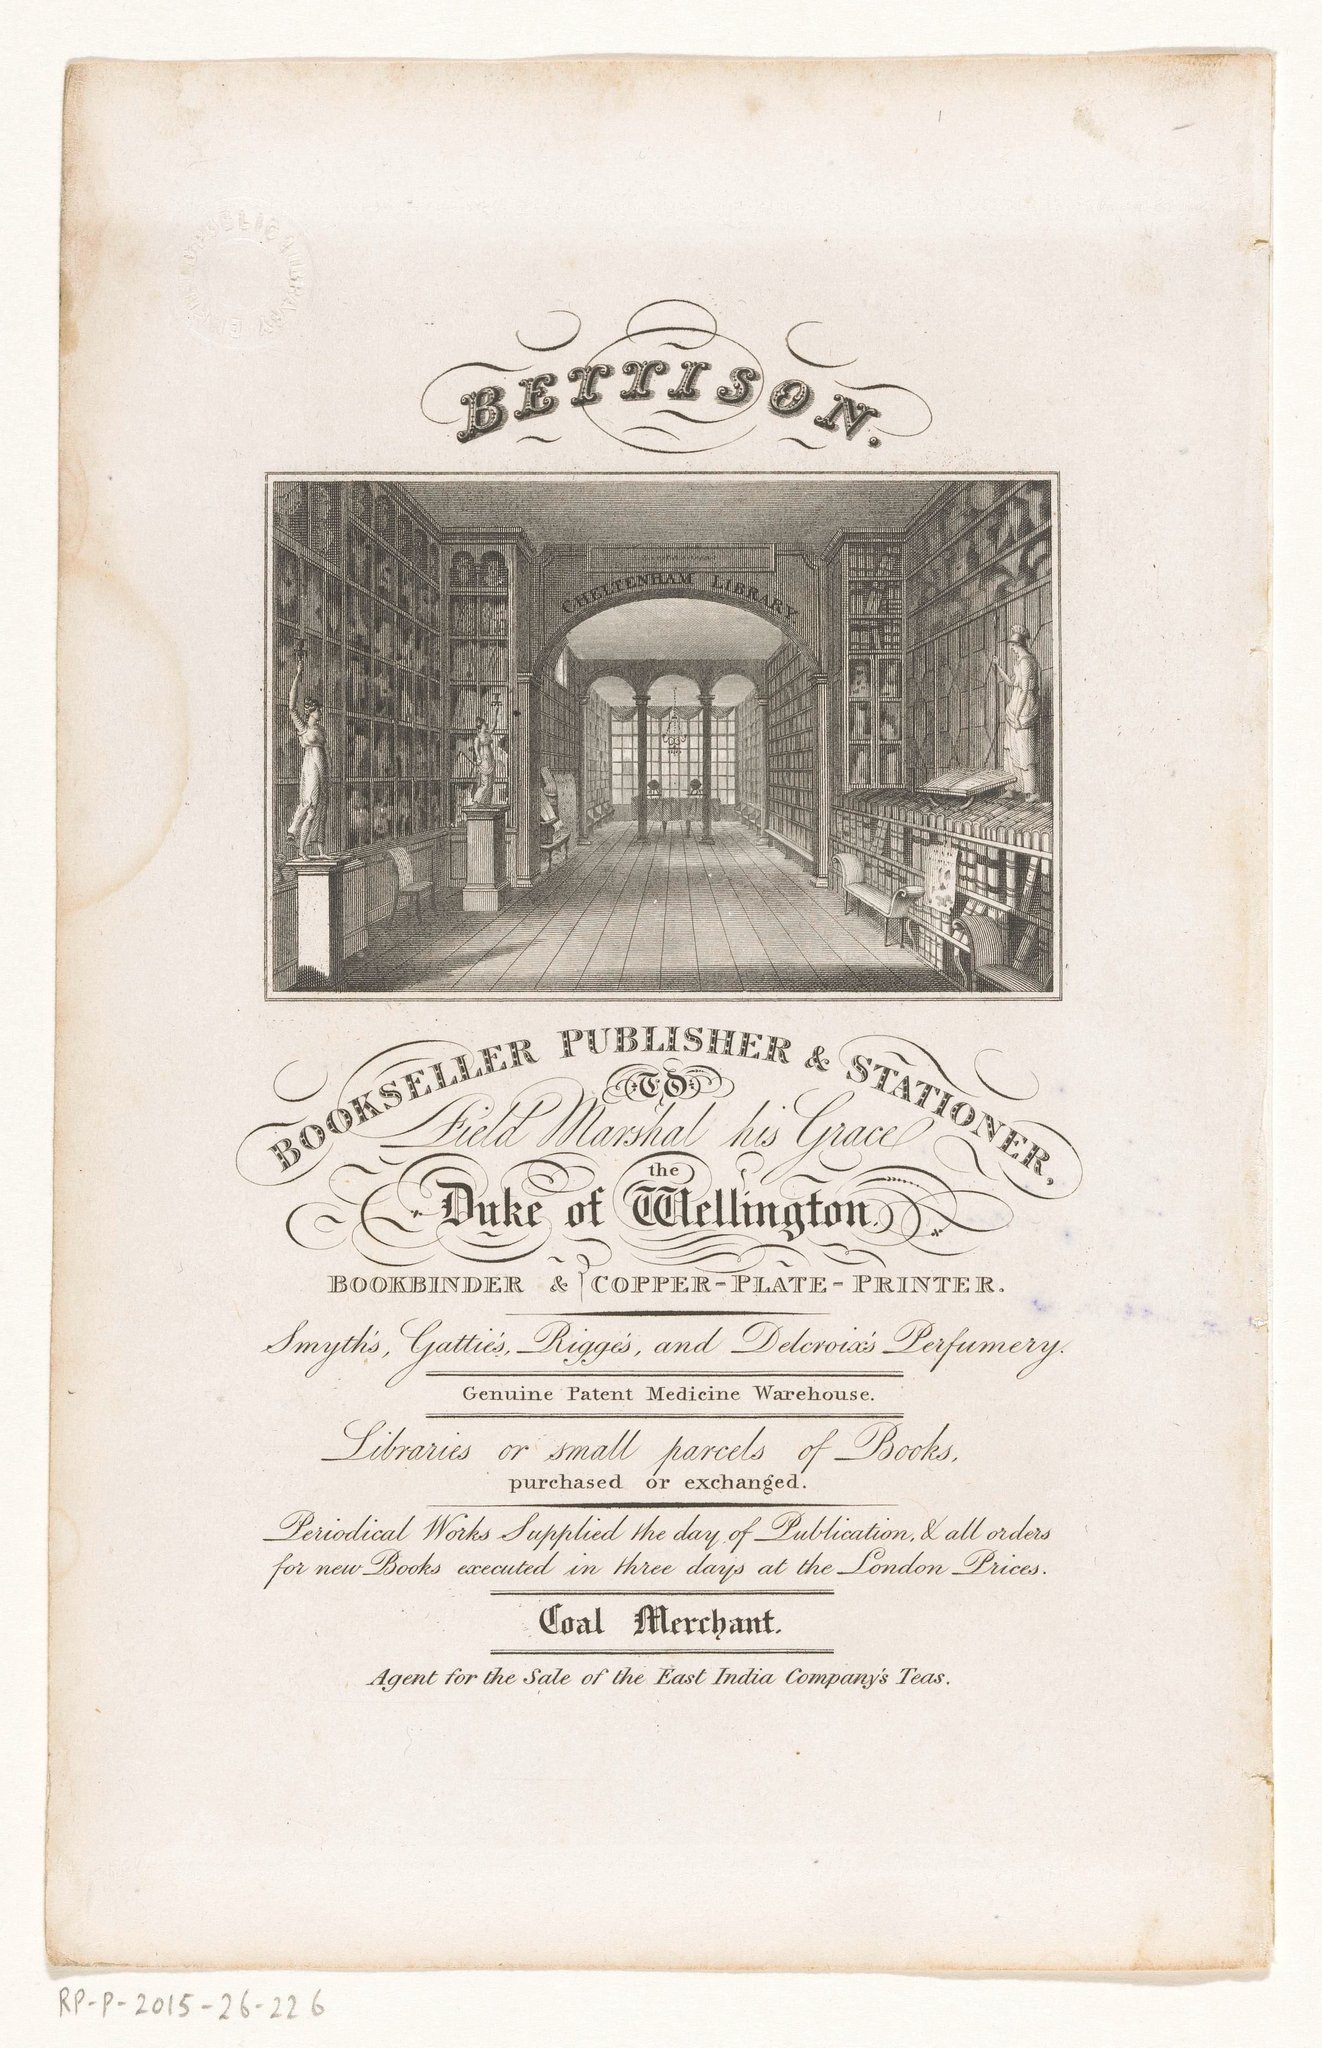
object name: book illustration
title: Visitekaartje van boekverkoper Bettison te Cheltenham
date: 1826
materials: paper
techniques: engraving, etching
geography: cheltenham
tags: specific aspects, allegorical aspects of minerva; minerva as patroness, public library, book-shop, bookseller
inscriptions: collector's mark: Lugt 4779, collector's mark: Lugt 2228, check stamp: ‘Enfield Public Library’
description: Interieur van de Cheltenham Library, voor de wanden met boeken enkele meubels en beelden, voor het raam een tafel met twee globes. Naast boekverkoper was Bettison ook uitgever, boekbinder, drukker en handelaar in parfum, thee en kolen.